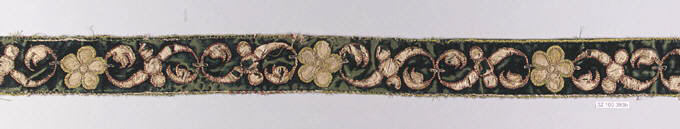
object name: border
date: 1501-1600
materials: metal thread, silk, velvet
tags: flowers